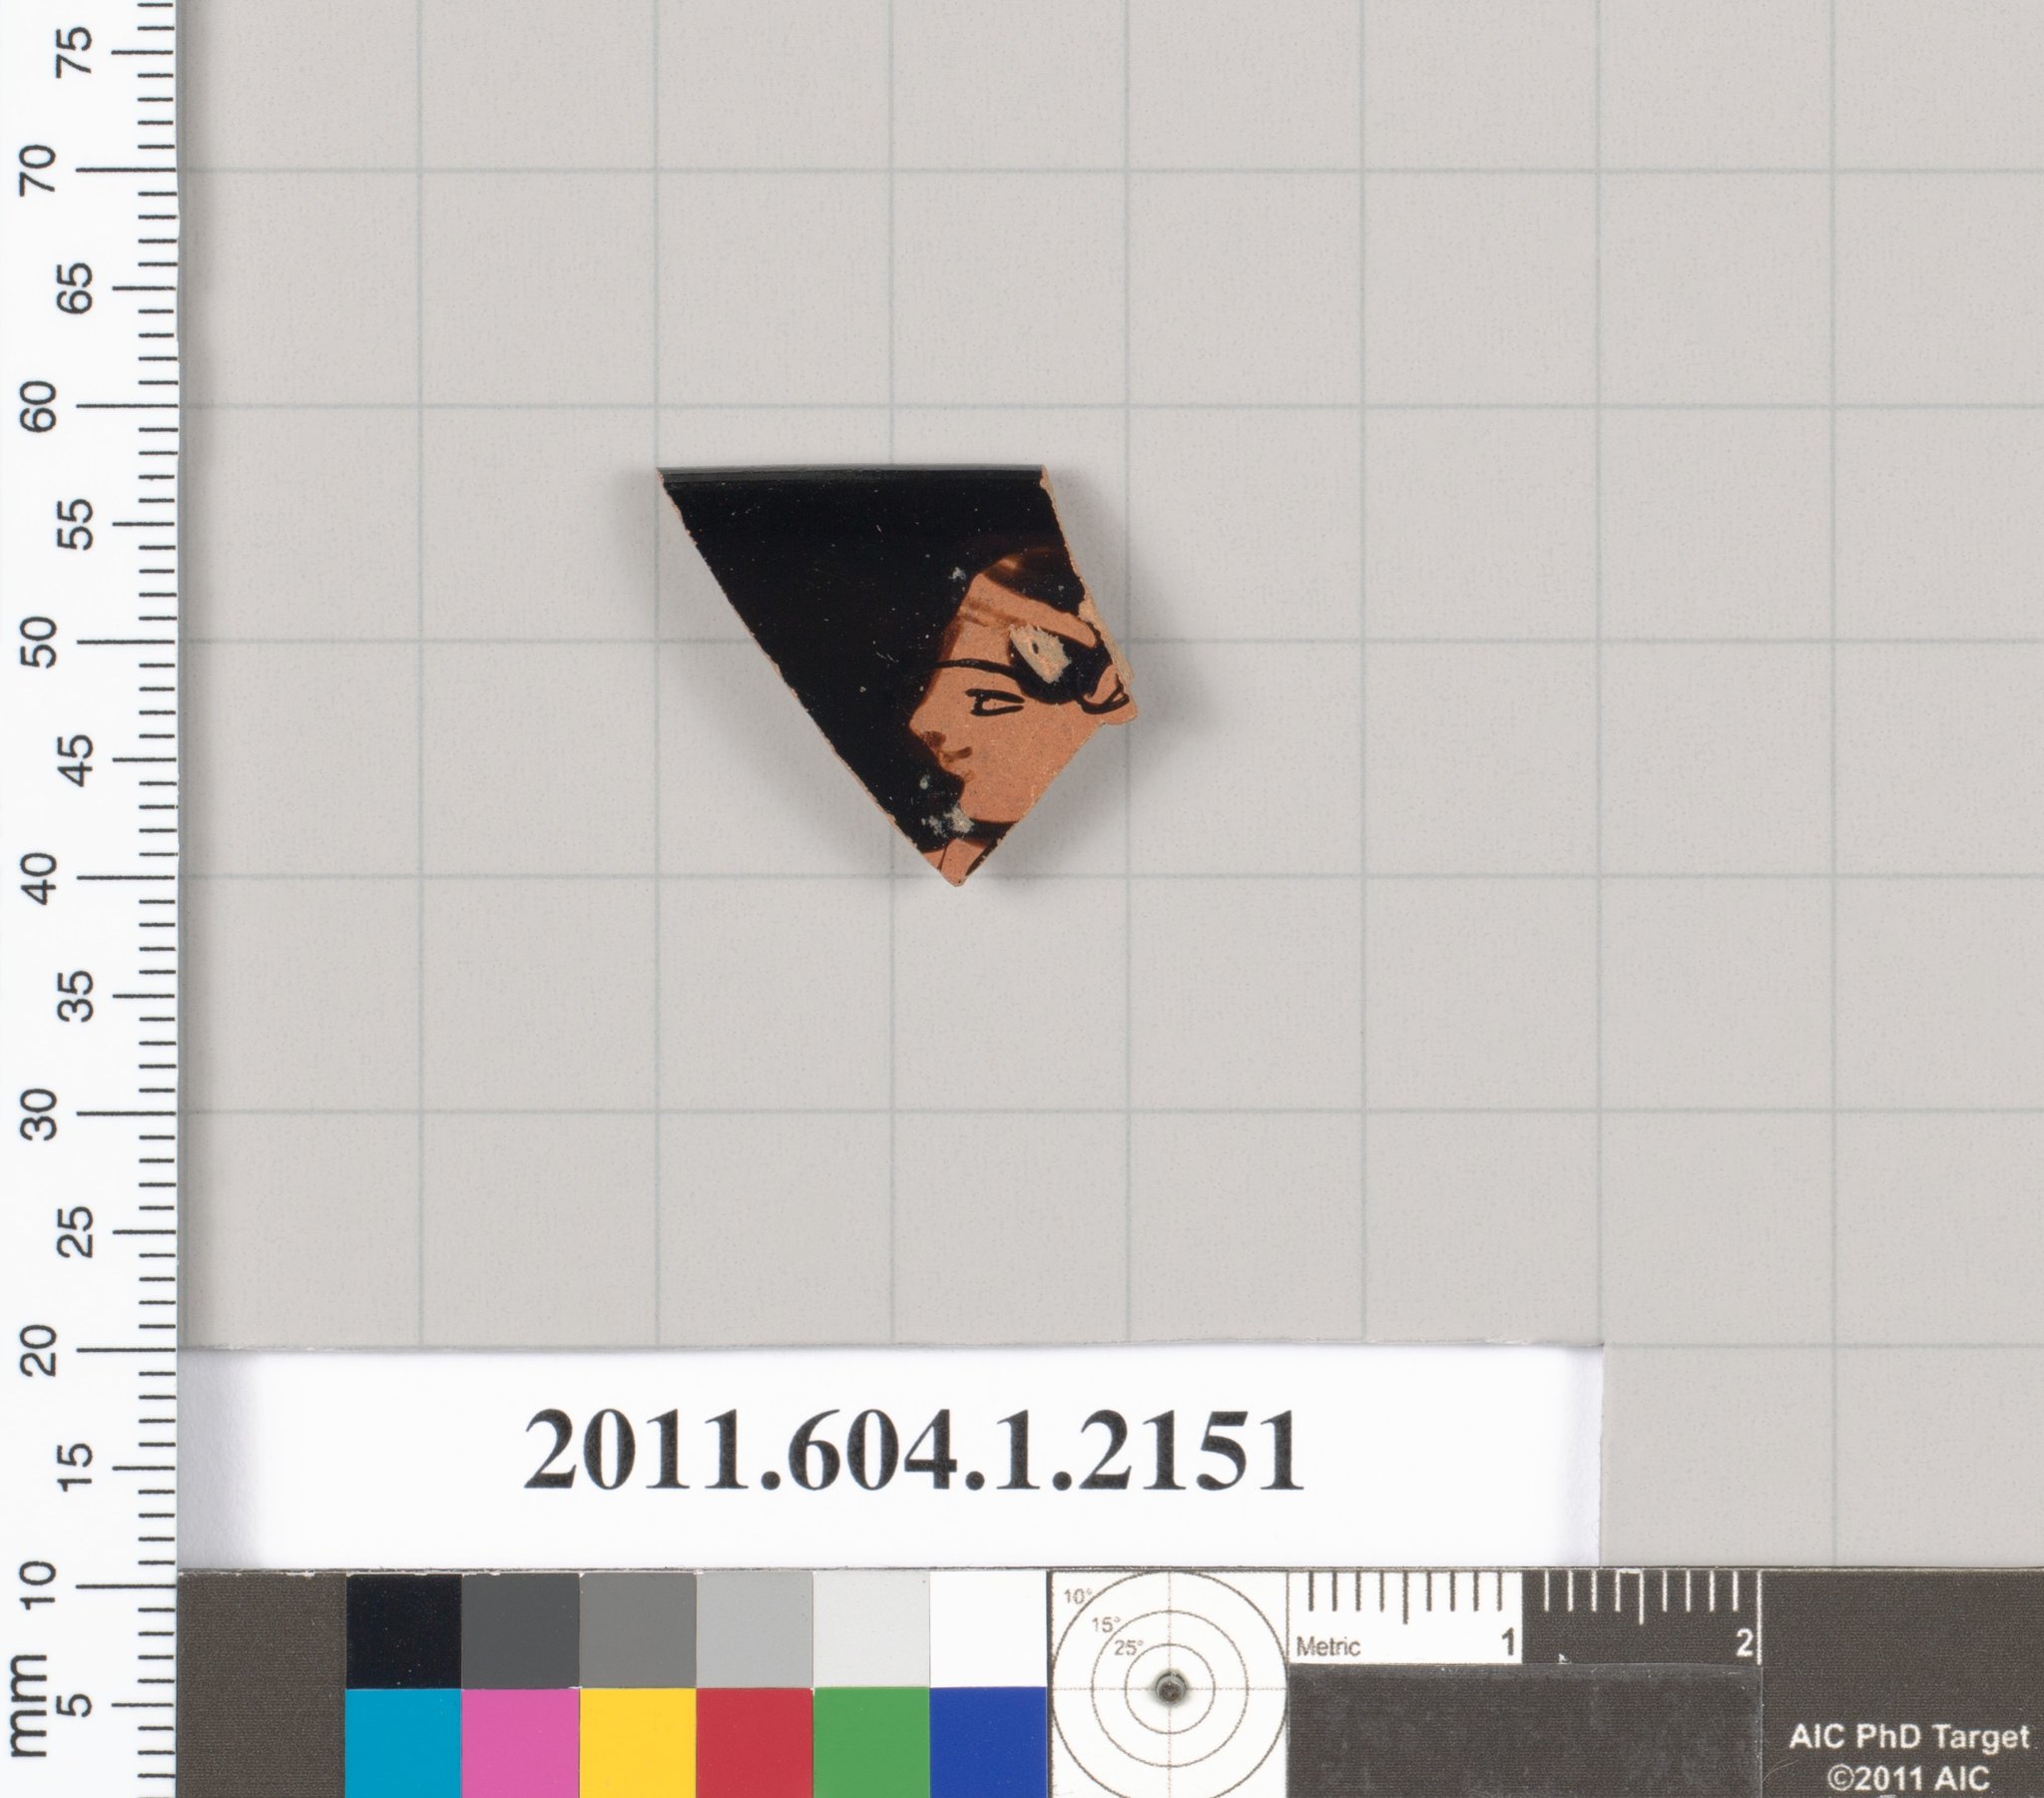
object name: kylix fragment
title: Terracotta rim fragment of a kylix (drinking cup)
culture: greek, attic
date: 467-435 BCE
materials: terracotta